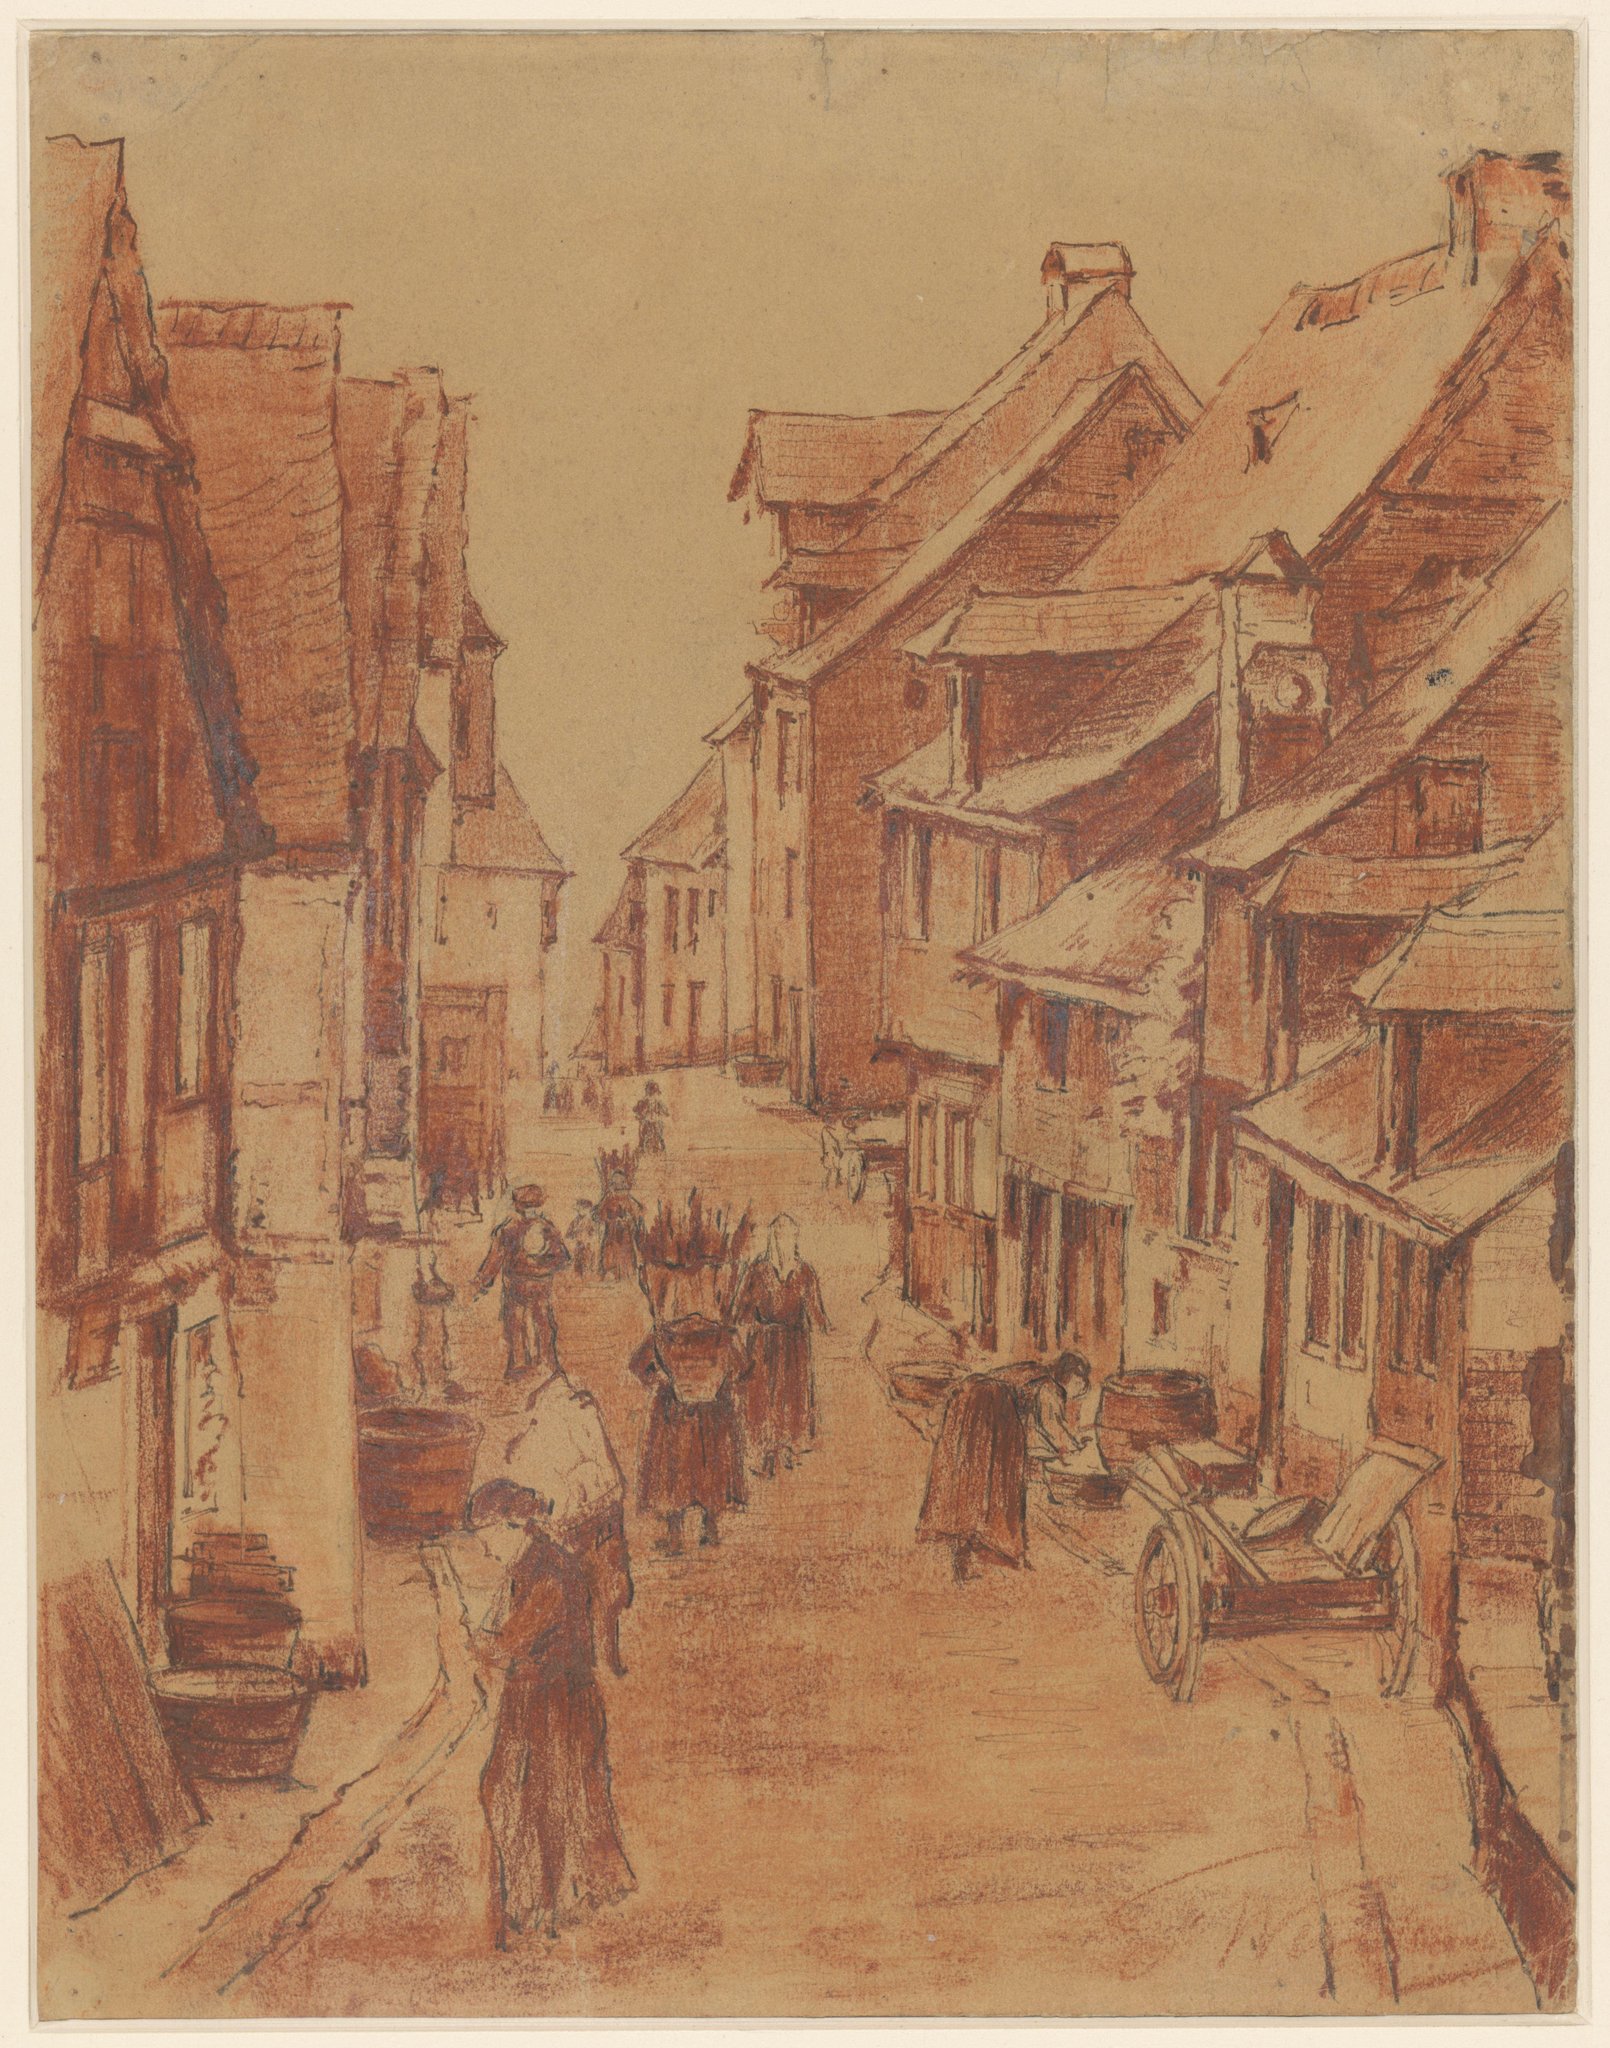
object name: drawing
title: Straatje in een Duits dorp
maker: froukje wartena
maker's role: draughtsman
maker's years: 1857-1933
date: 1867-1933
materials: chalk, paper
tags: village street, germany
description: Straatje in een Duits dorp, met boerenvrouwen met manden op de rug.